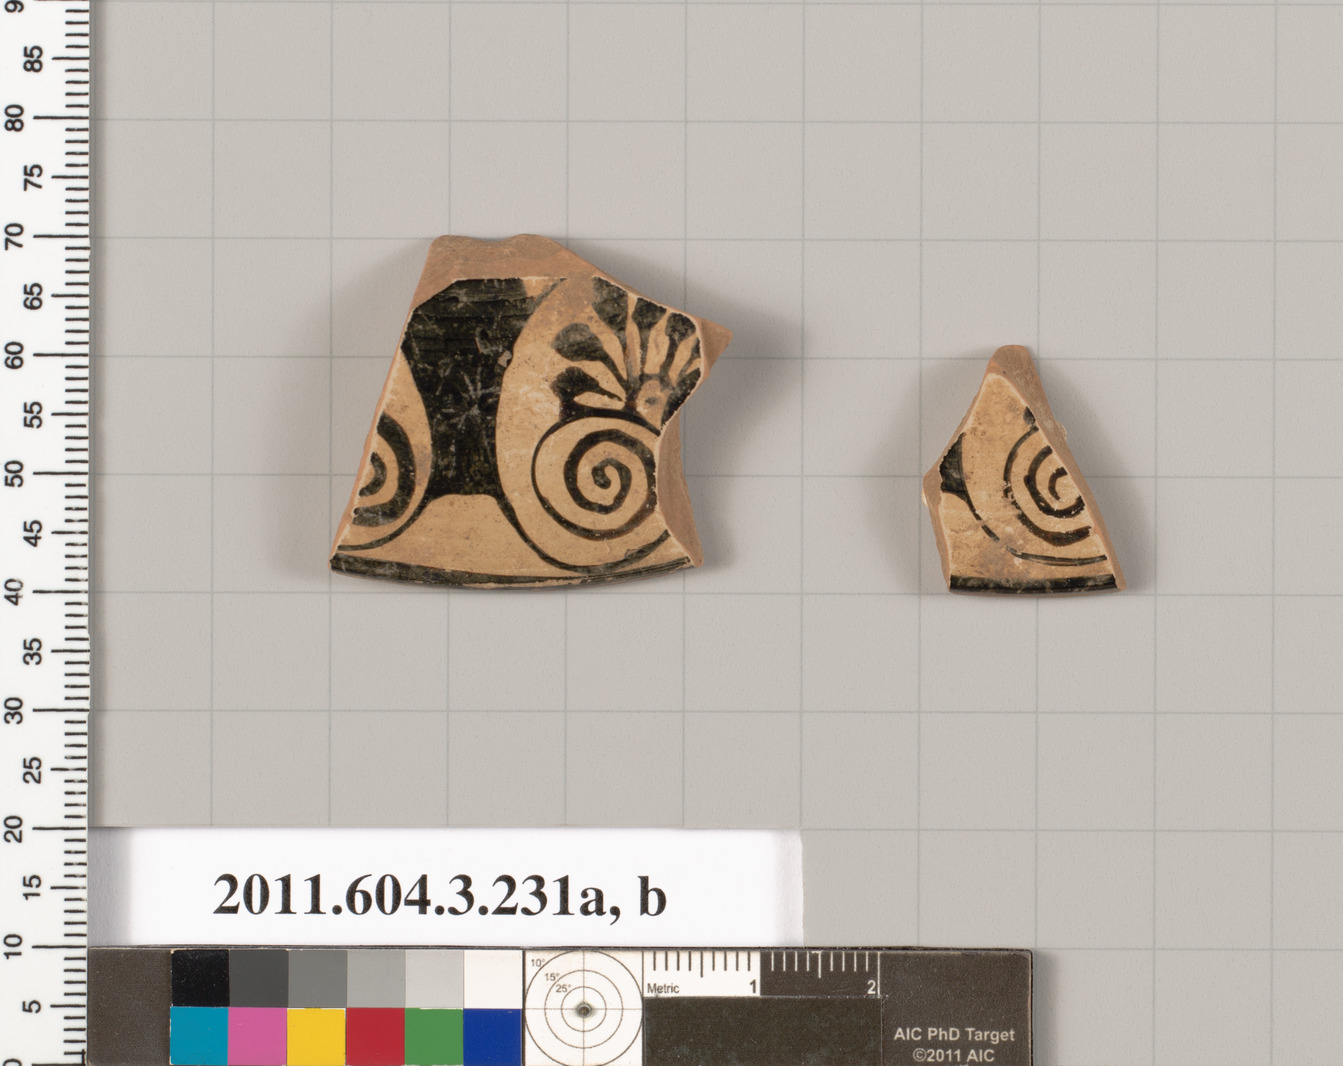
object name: neck amphora fragment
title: Terracotta fragments of a neck-amphora of Nicosthenic shape (jar)?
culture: greek, attic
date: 500-468 BCE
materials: terracotta